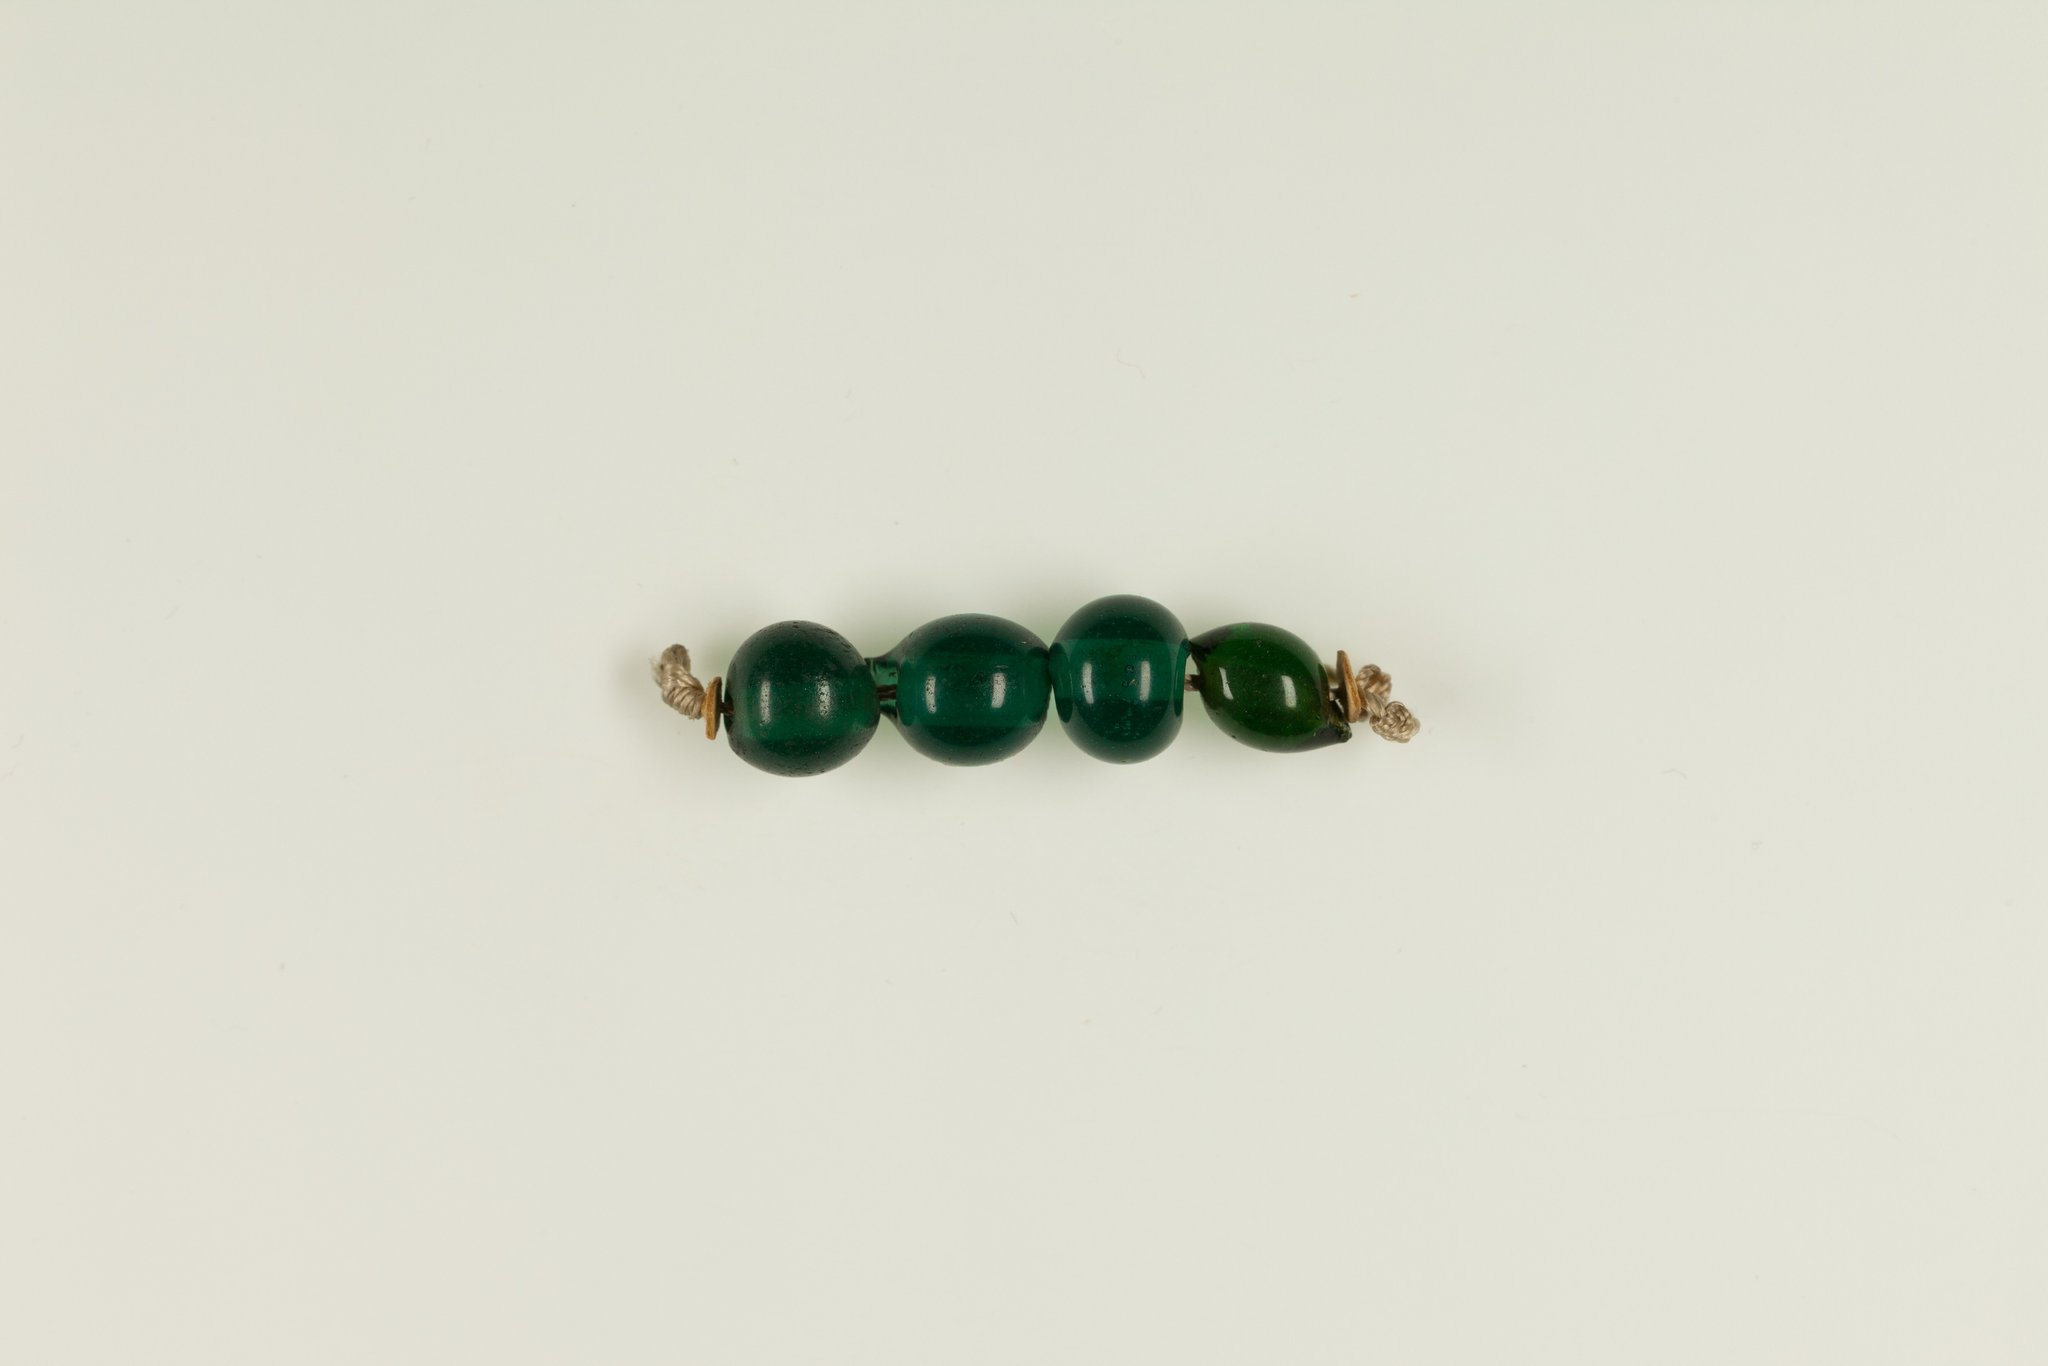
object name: bead, string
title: String of 4 spheroid beads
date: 1186-664 BCE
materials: glass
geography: egypt